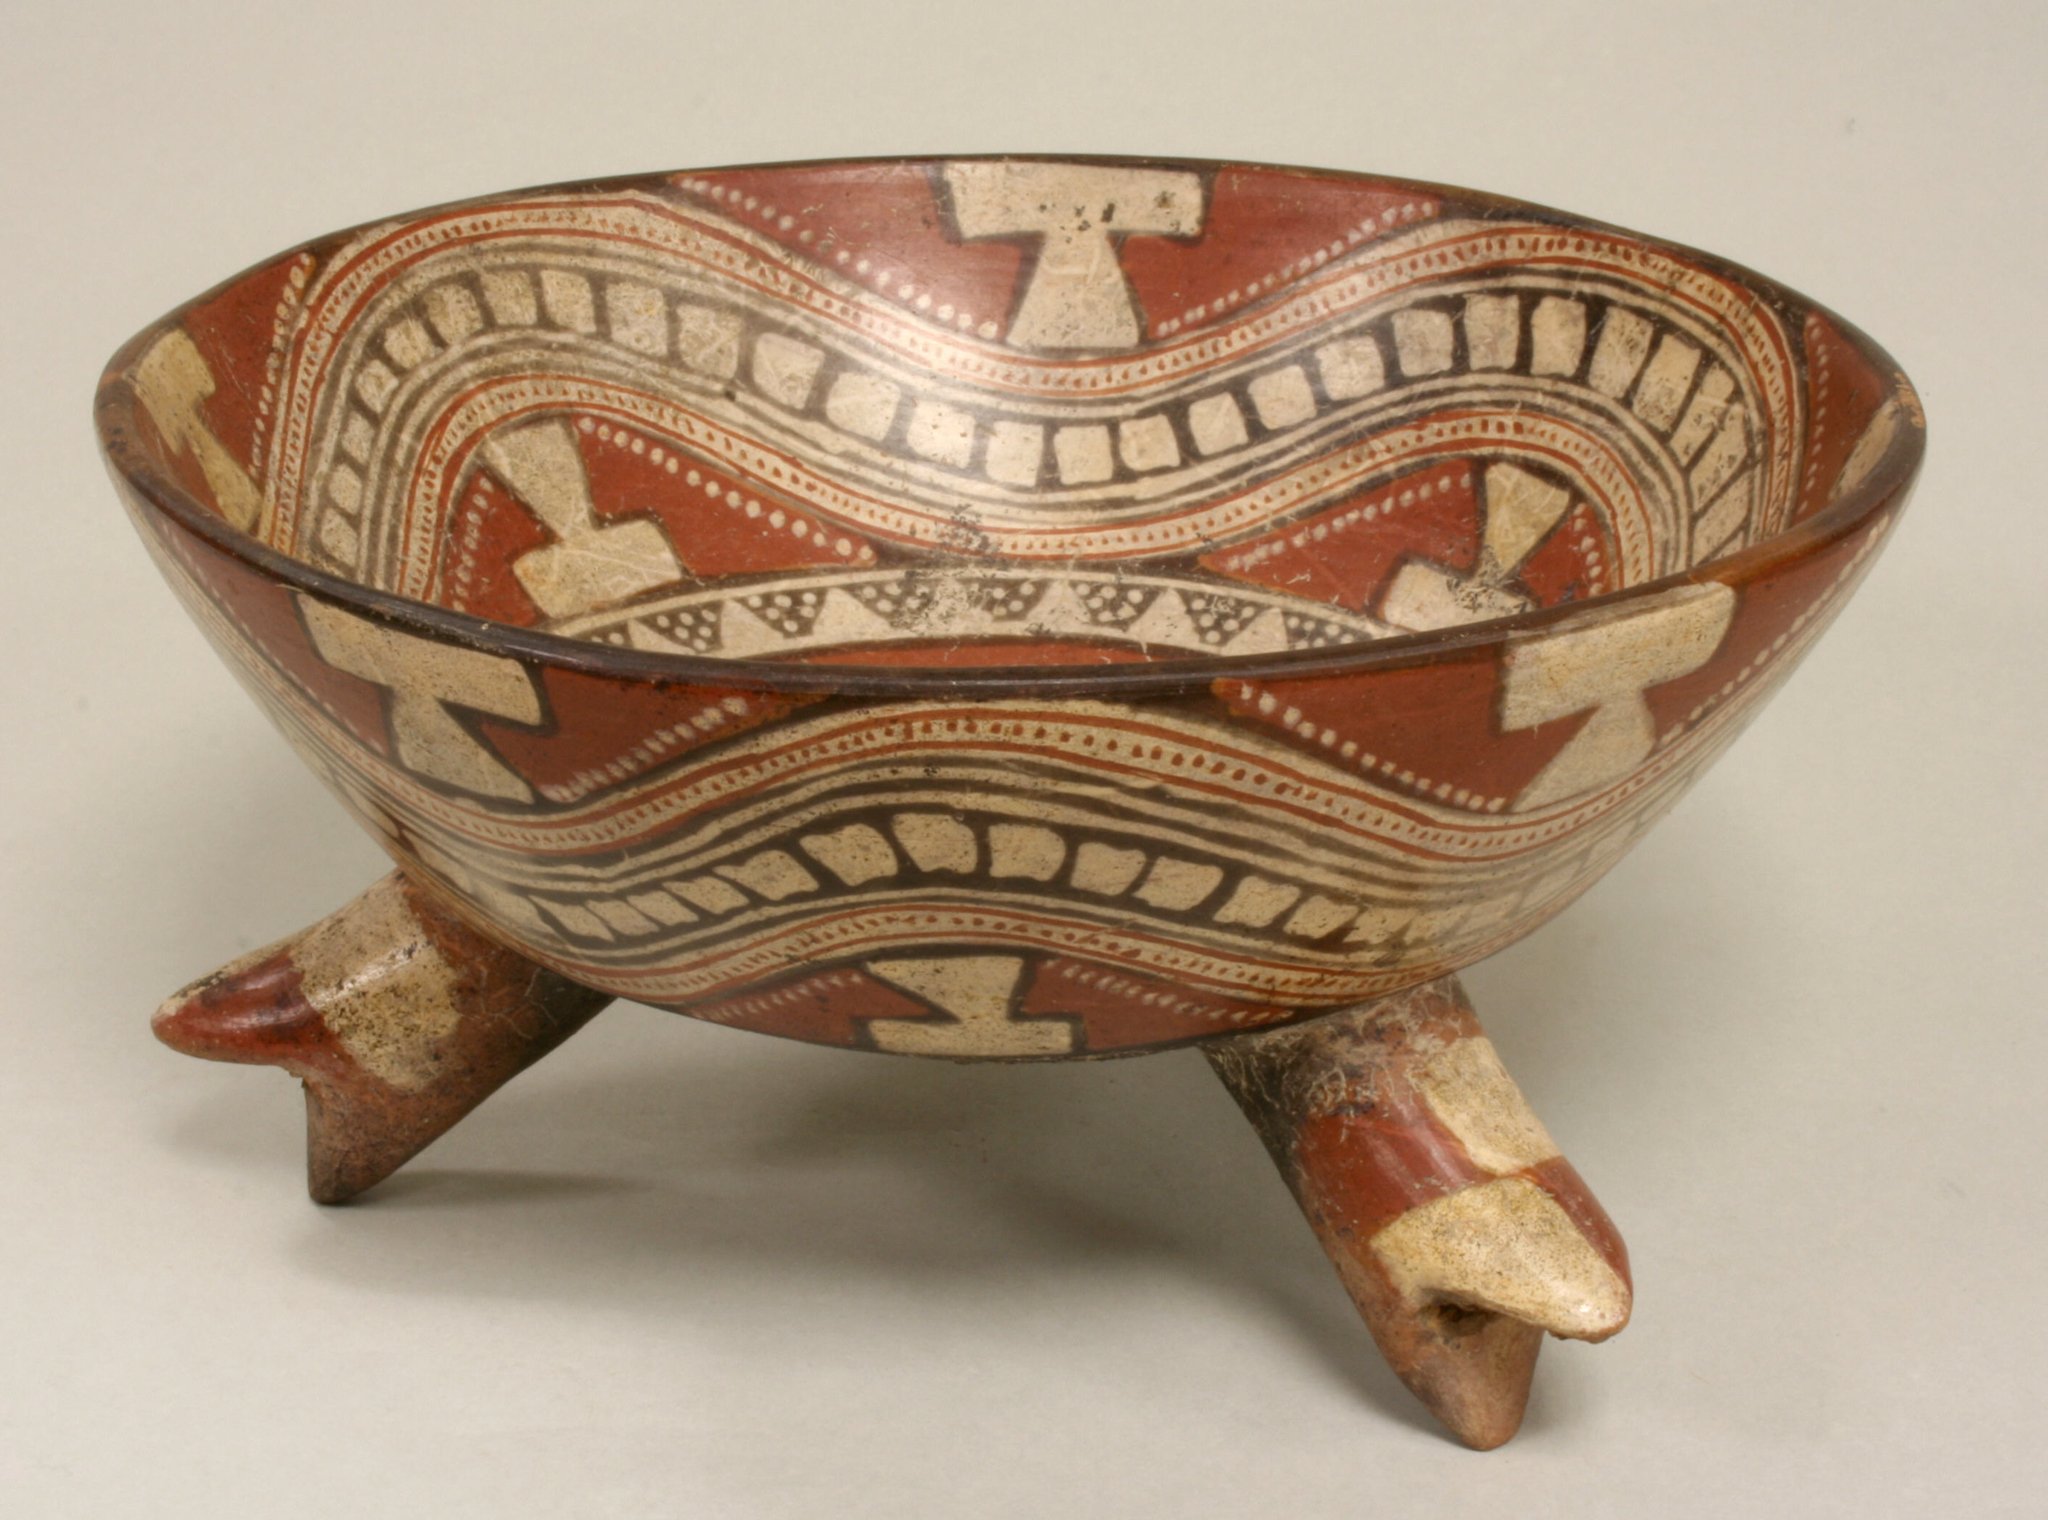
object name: bowl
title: Ceramic Tripod Vessel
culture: mexican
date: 801-1200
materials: ceramic, pigment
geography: mexico